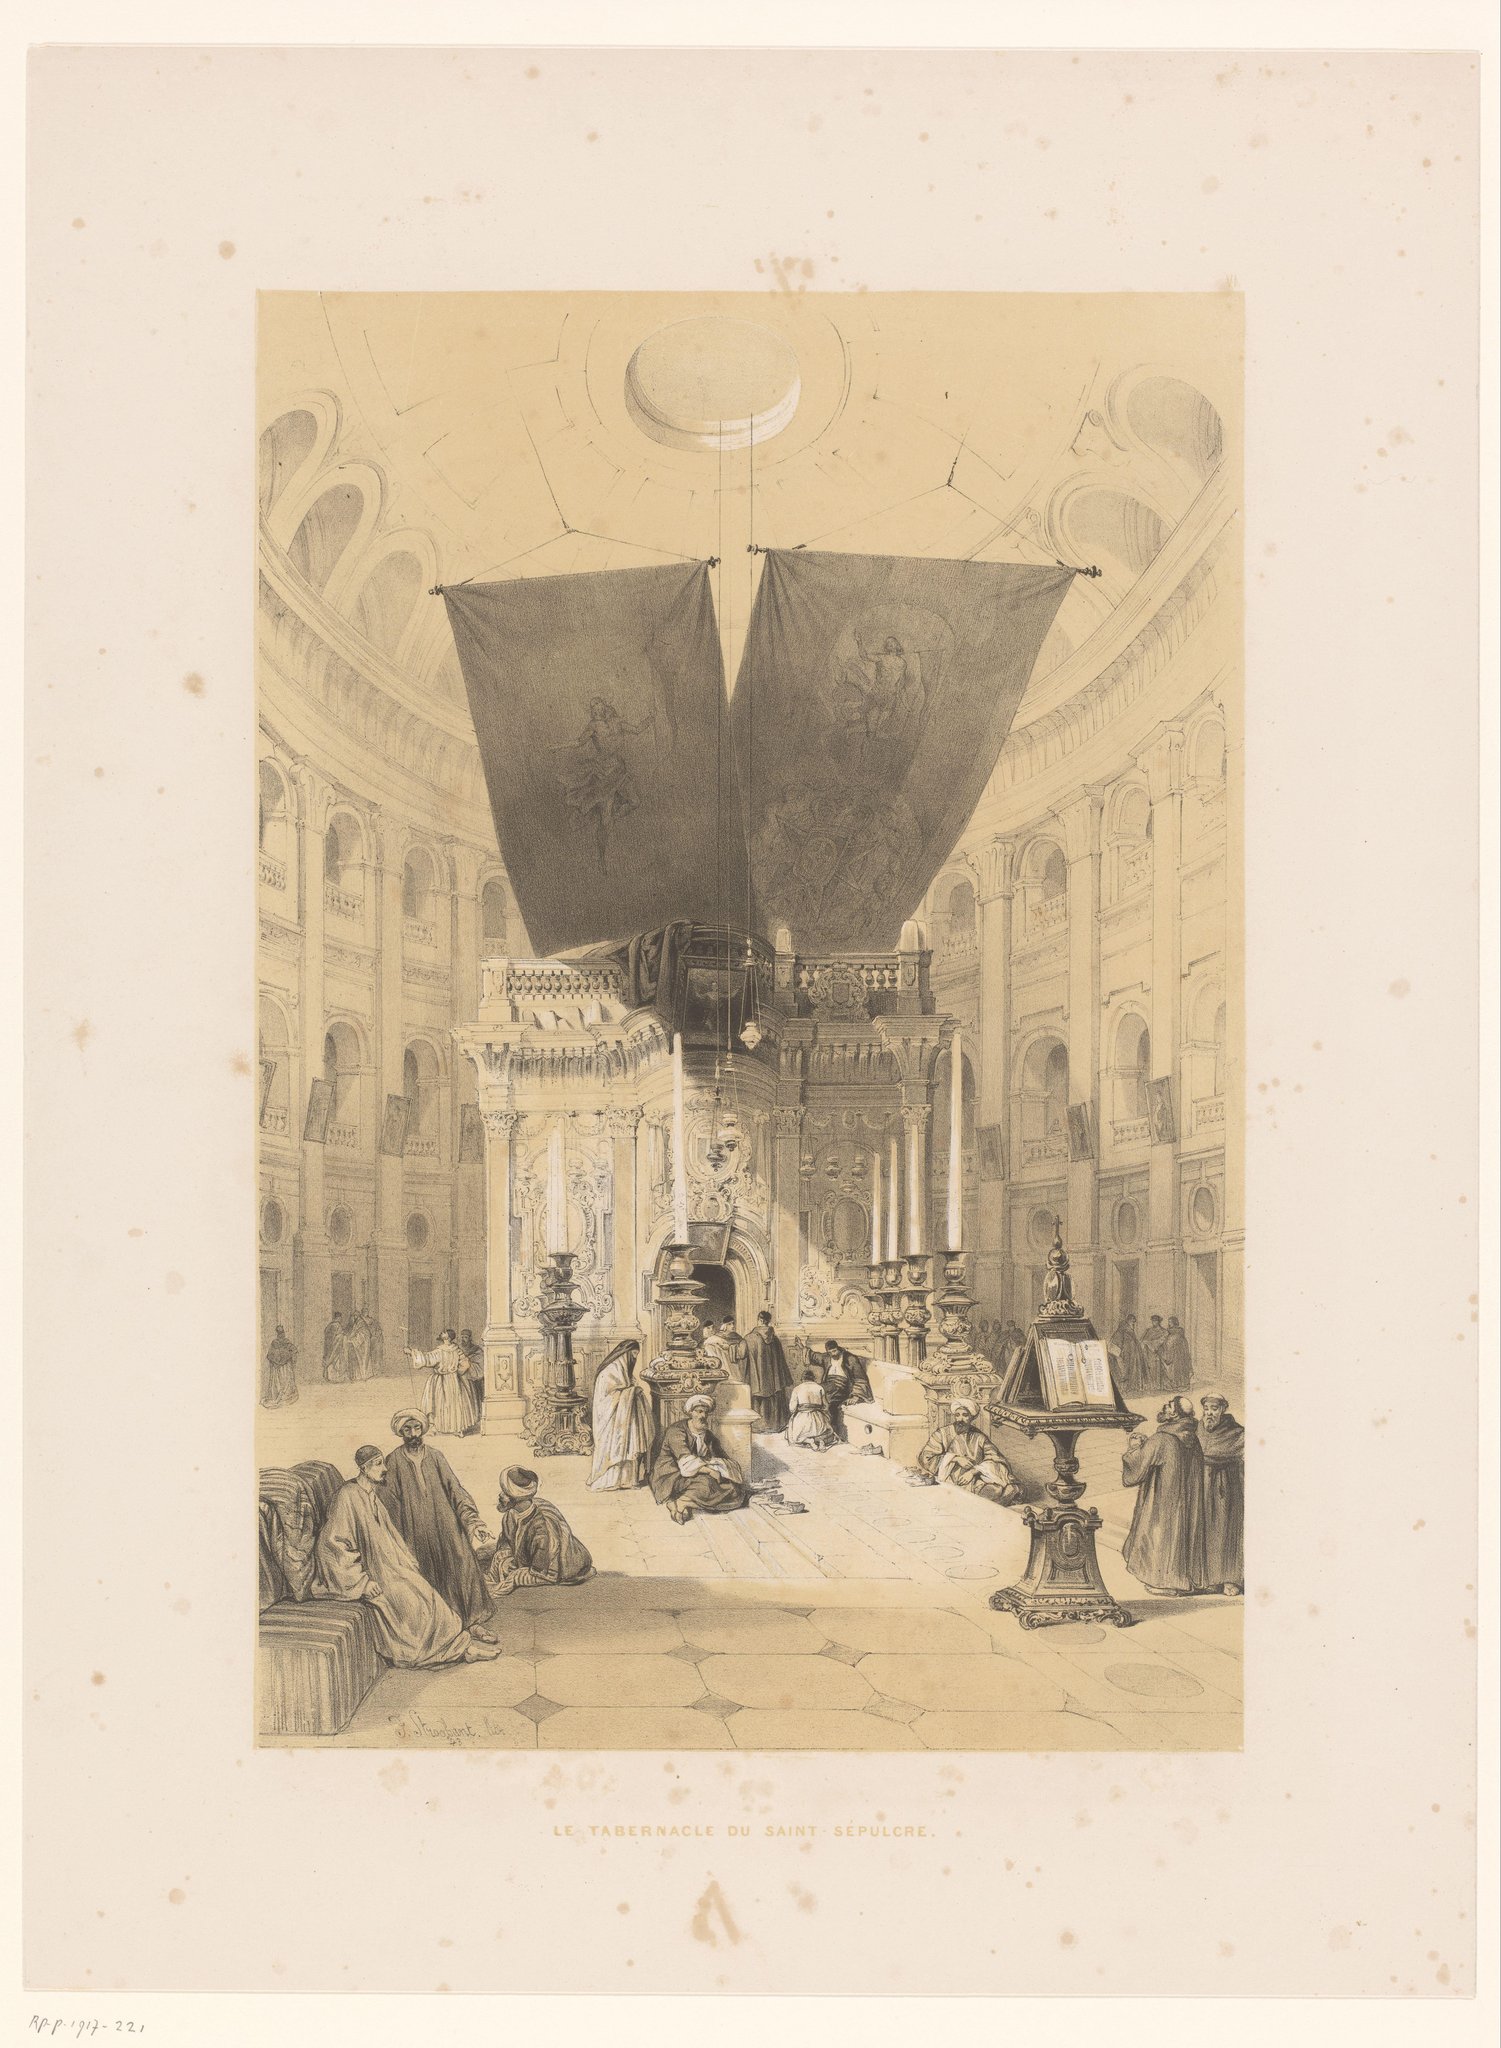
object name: print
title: La terre sainte. Vues & monuments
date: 1852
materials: paper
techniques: tone lithography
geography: brussels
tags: interior of church, tabernacle ~ altar, public worship and liturgy of the christian churches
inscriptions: collector's mark: Lugt 2228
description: Jules Géruzet maakt in 1852 een heruitgave van het Belgische werk 'La terre sainte. Vues et monuments recueillis par David Roberts de l'Académie de Londres' dat tussen 1843-1845 wordt gedrukt door J. Lots en waarvan de prenten, op verzoek van de Société des Beaux-Arts, door Ghemar en Stroobant worden uitgevoerd naar werken van Haghe.